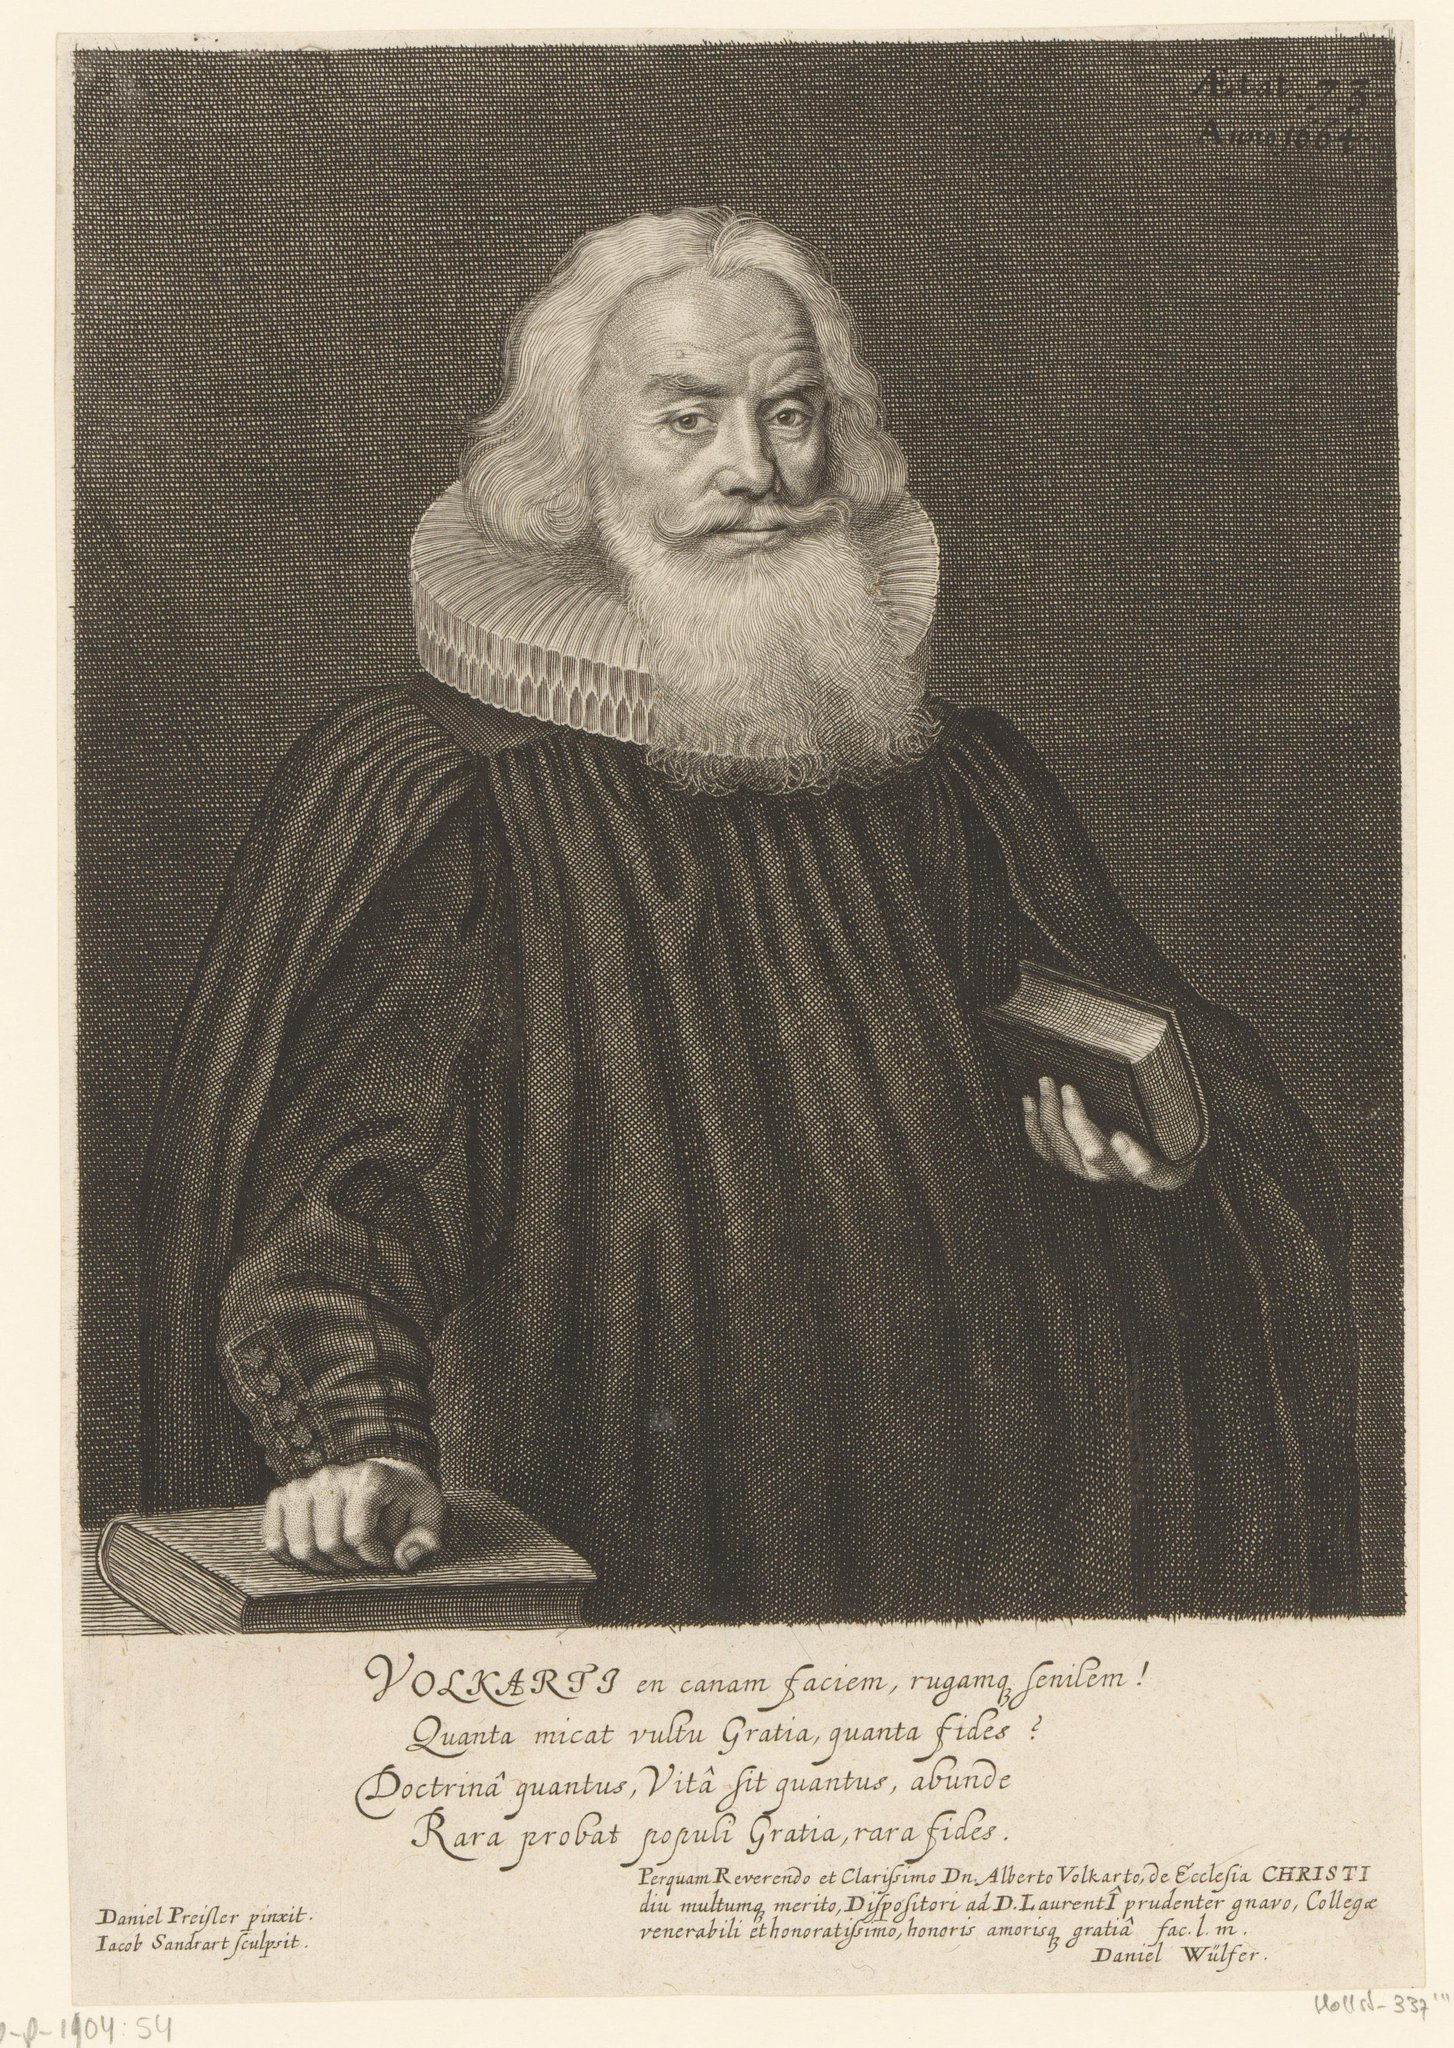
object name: print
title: Portret van Albrecht Volckhard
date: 1666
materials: paper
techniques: engraving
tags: theologian, historical persons, book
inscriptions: collector's mark: Lugt 2228, collector's mark: Lugt 906